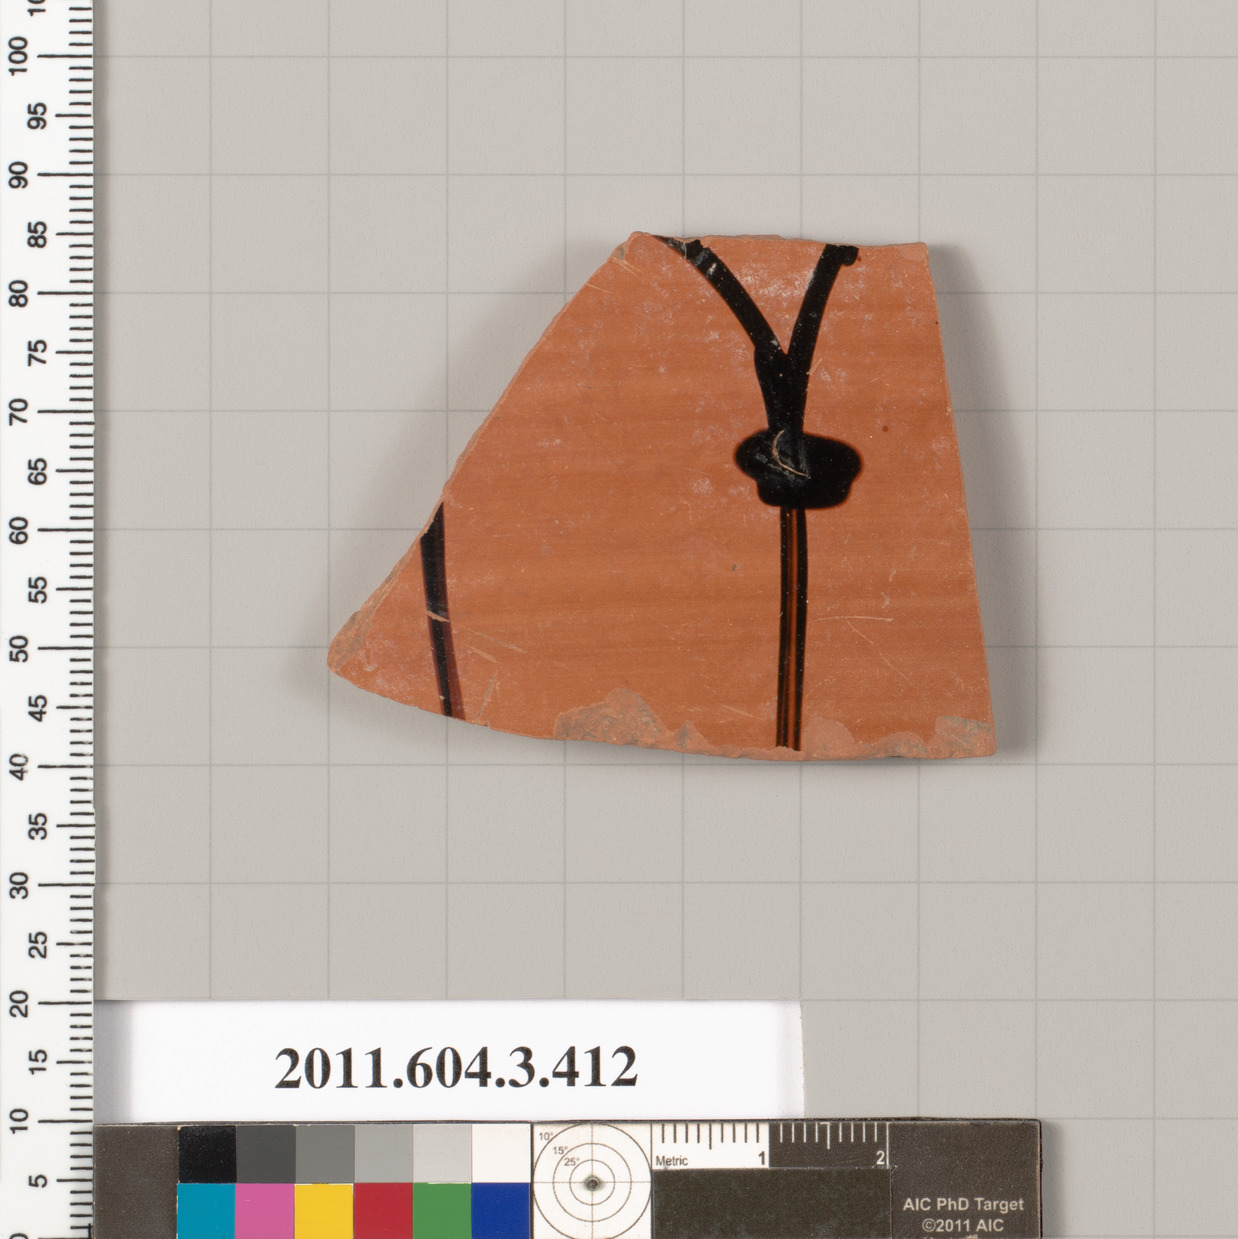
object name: neck amphora fragment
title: Terracotta fragment of a neck-amphora (jar)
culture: greek, attic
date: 500-468 BCE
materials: terracotta